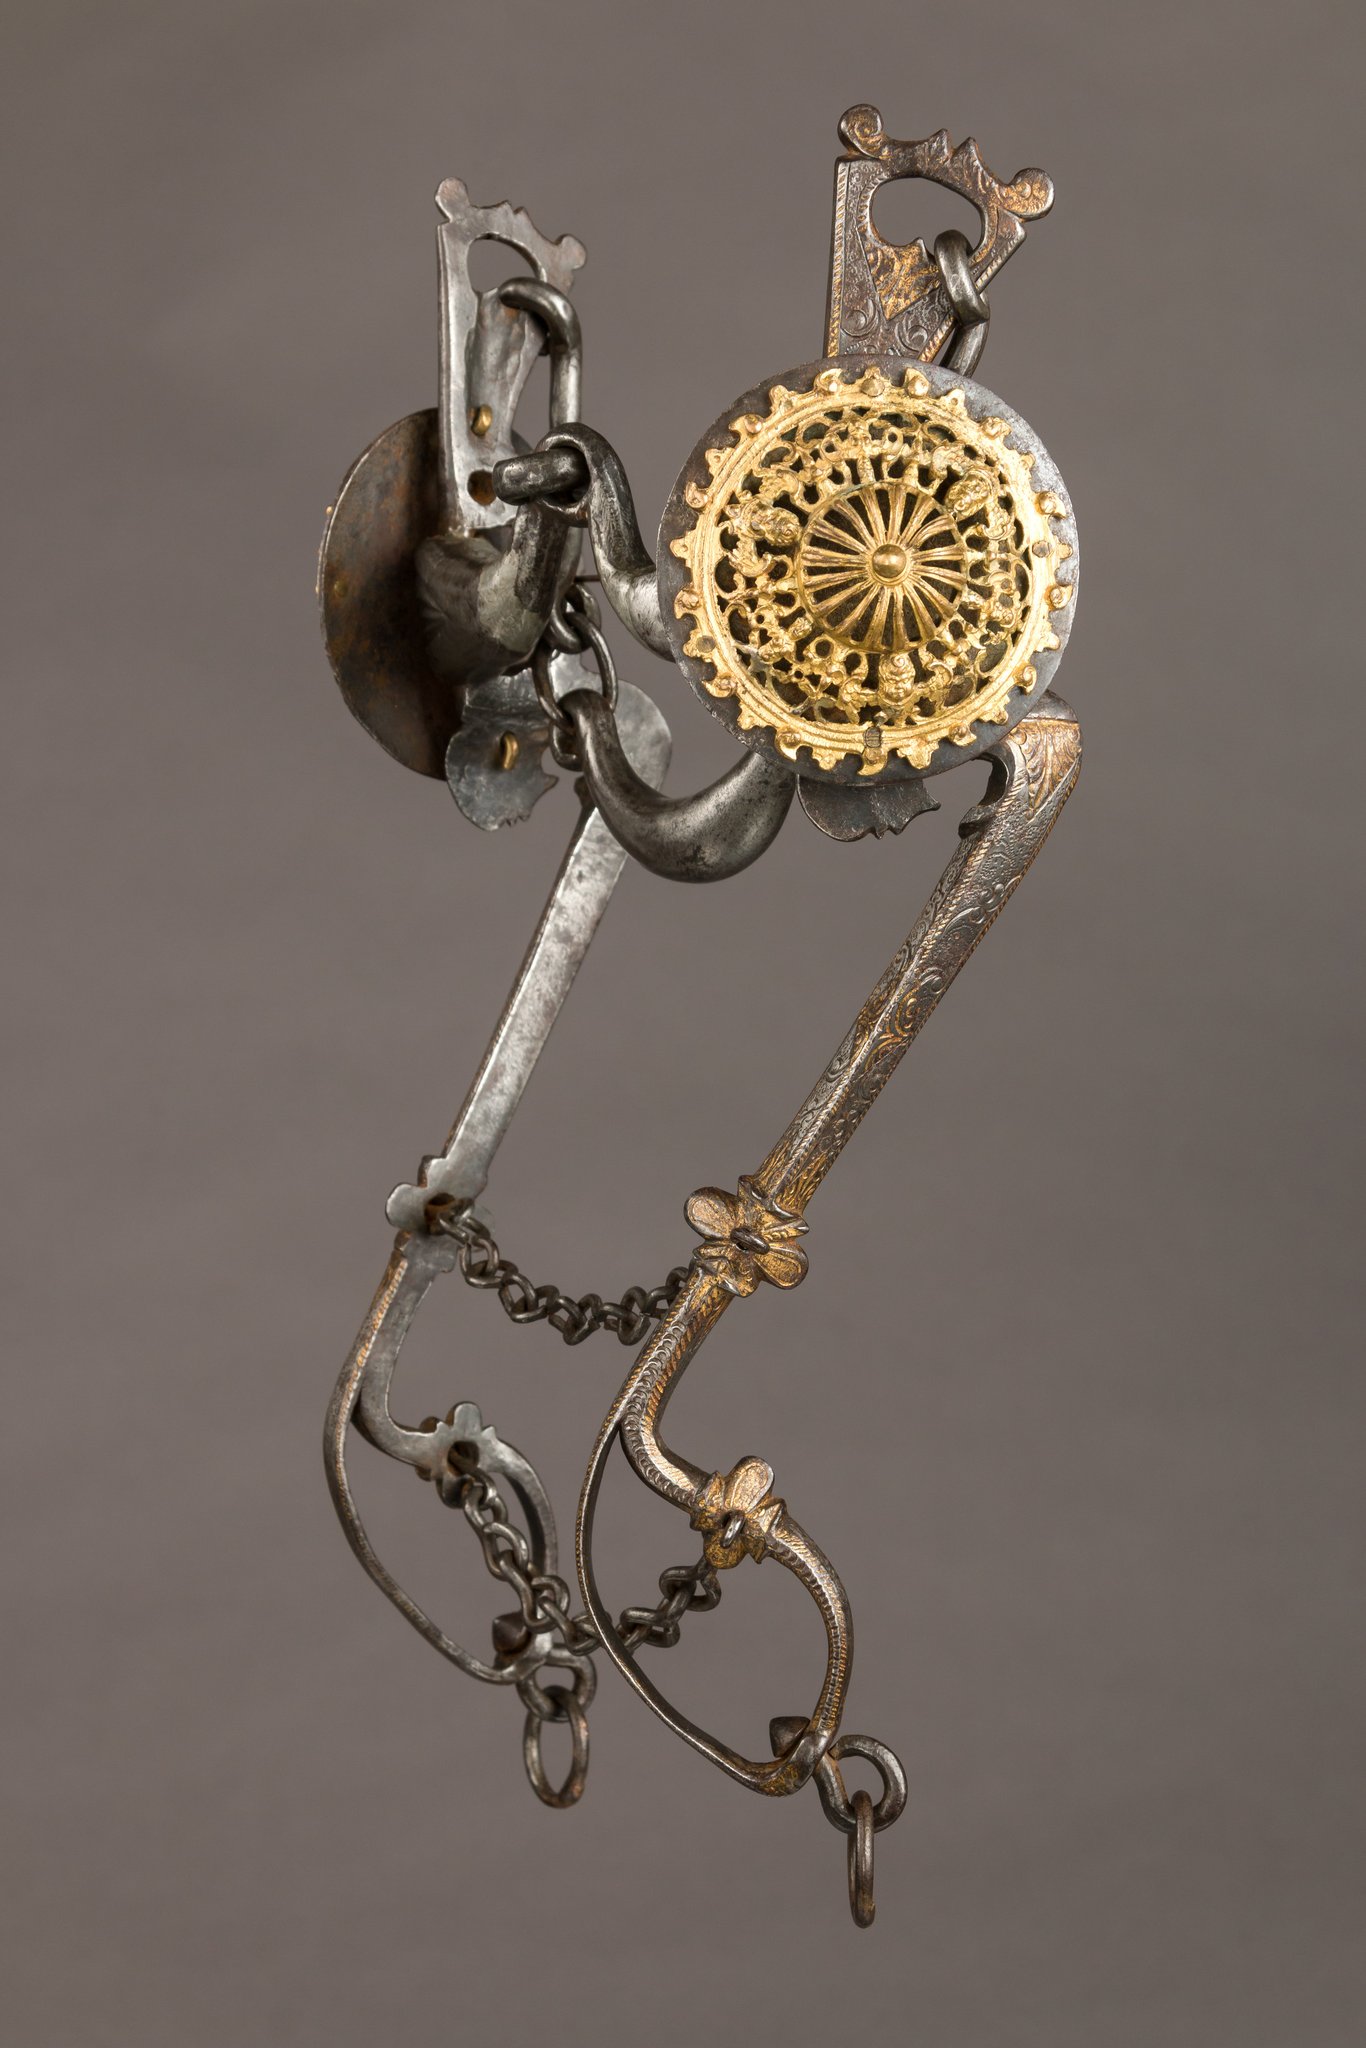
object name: bit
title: Curb Bit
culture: bit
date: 1601-1700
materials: copper alloy, gold, metal alloy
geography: netherlands